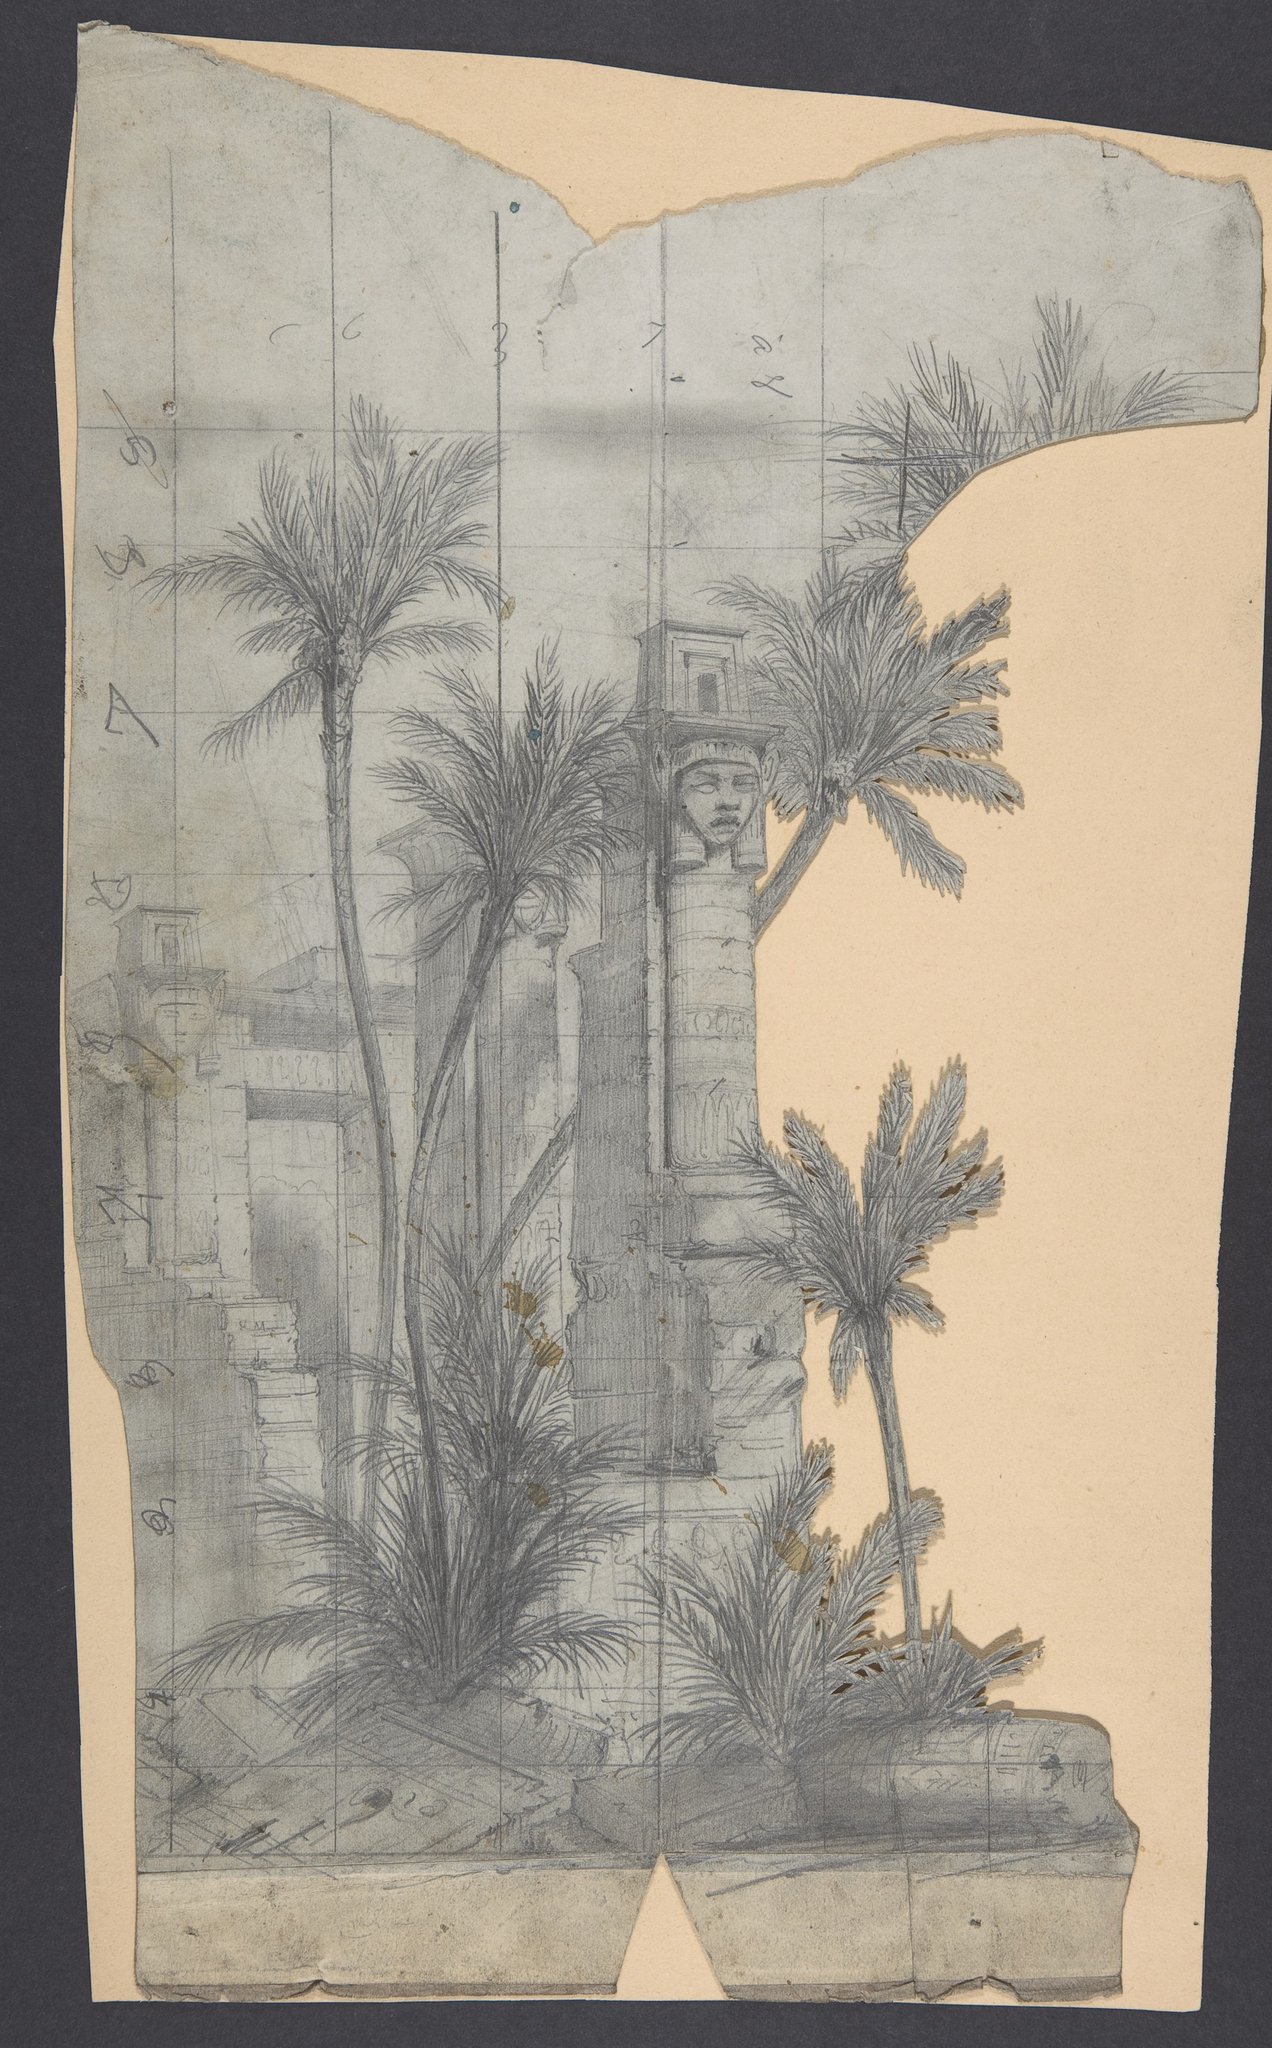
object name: drawing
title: Design for a Stage Set at the Opéra, Paris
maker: eugène cicéri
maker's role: artist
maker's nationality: french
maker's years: 1813-1890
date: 1830-1890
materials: graphite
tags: trees,stage design